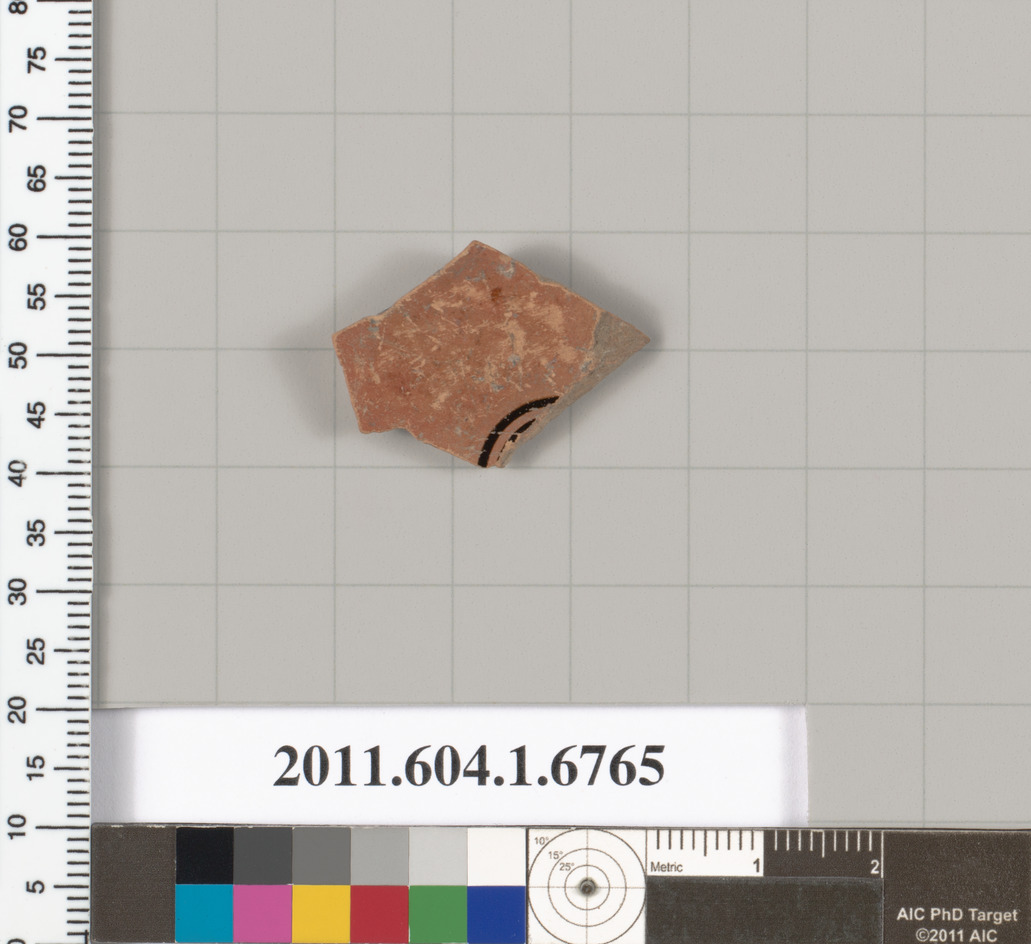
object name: kylix fragment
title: Terracotta fragment of a kylix (drinking cup)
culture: greek, attic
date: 490-470 BCE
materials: terracotta